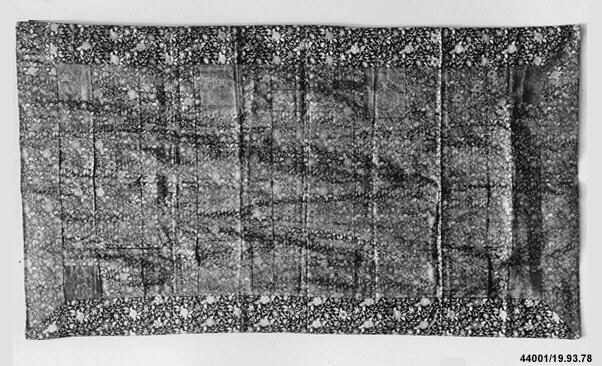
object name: robe, priest's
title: Priest's Robe (Shichijō)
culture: japanese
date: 1615-1868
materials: silk